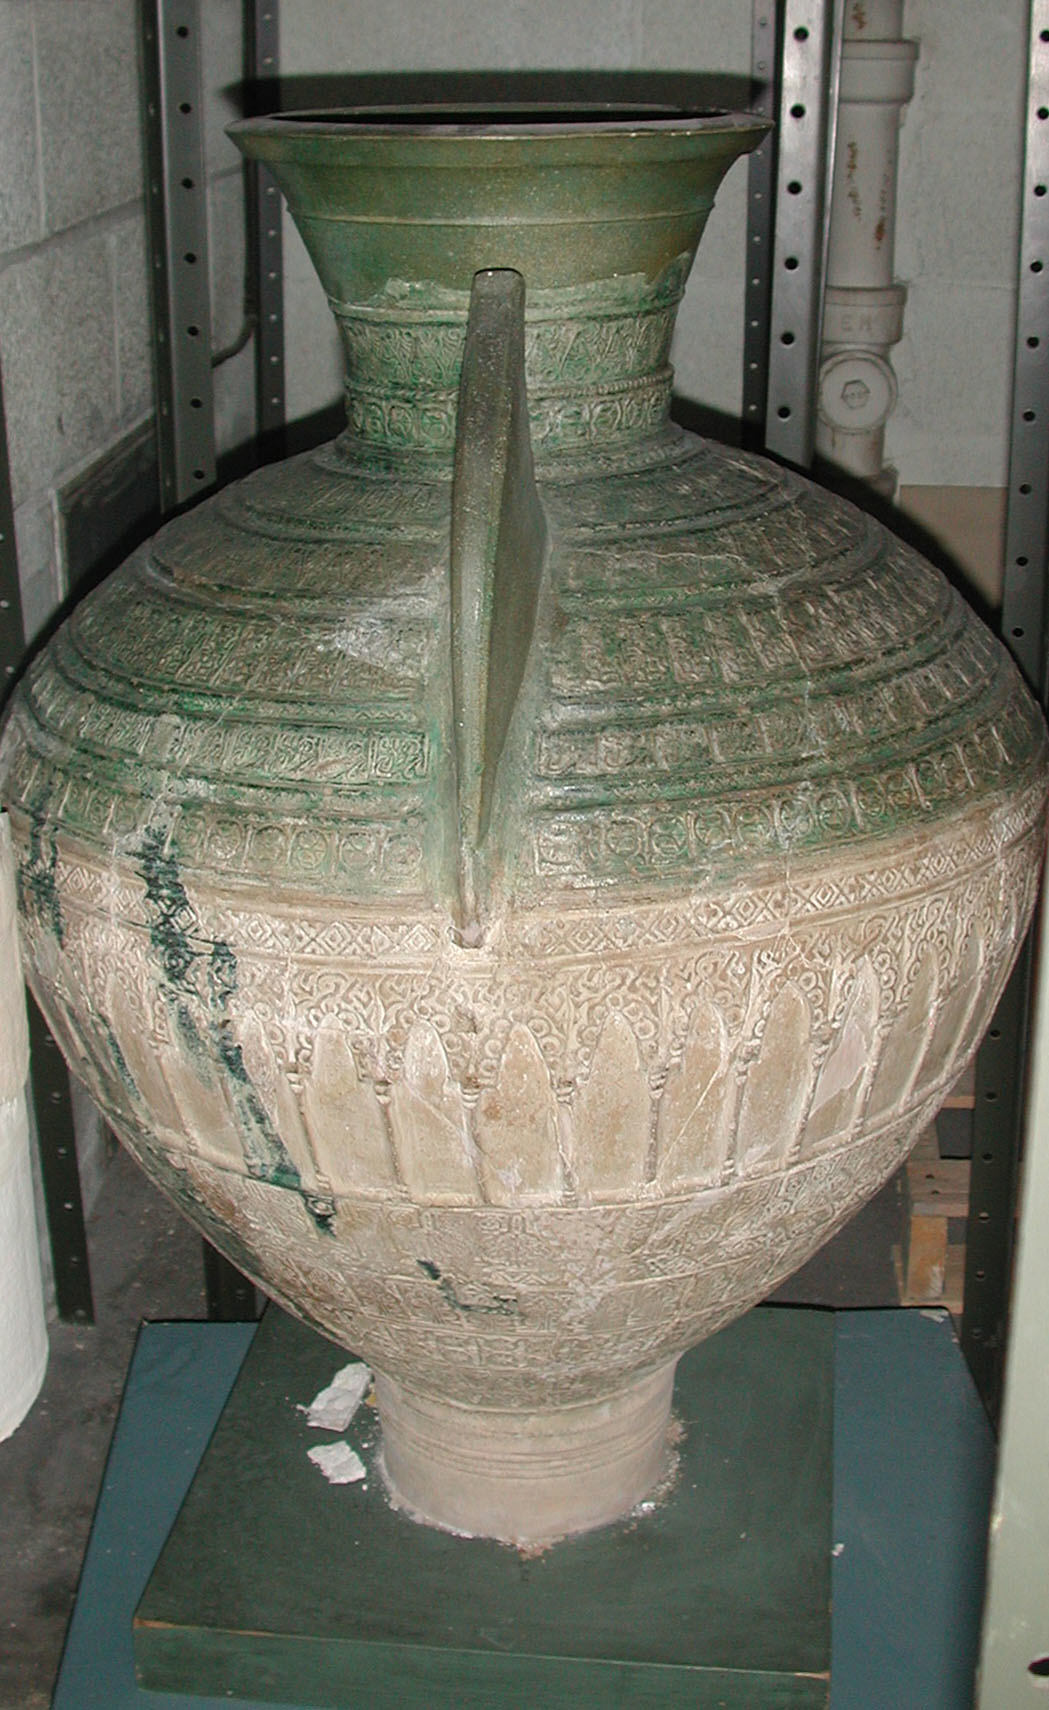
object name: jar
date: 1401-1500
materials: earthenware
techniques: glazing, molding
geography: spain